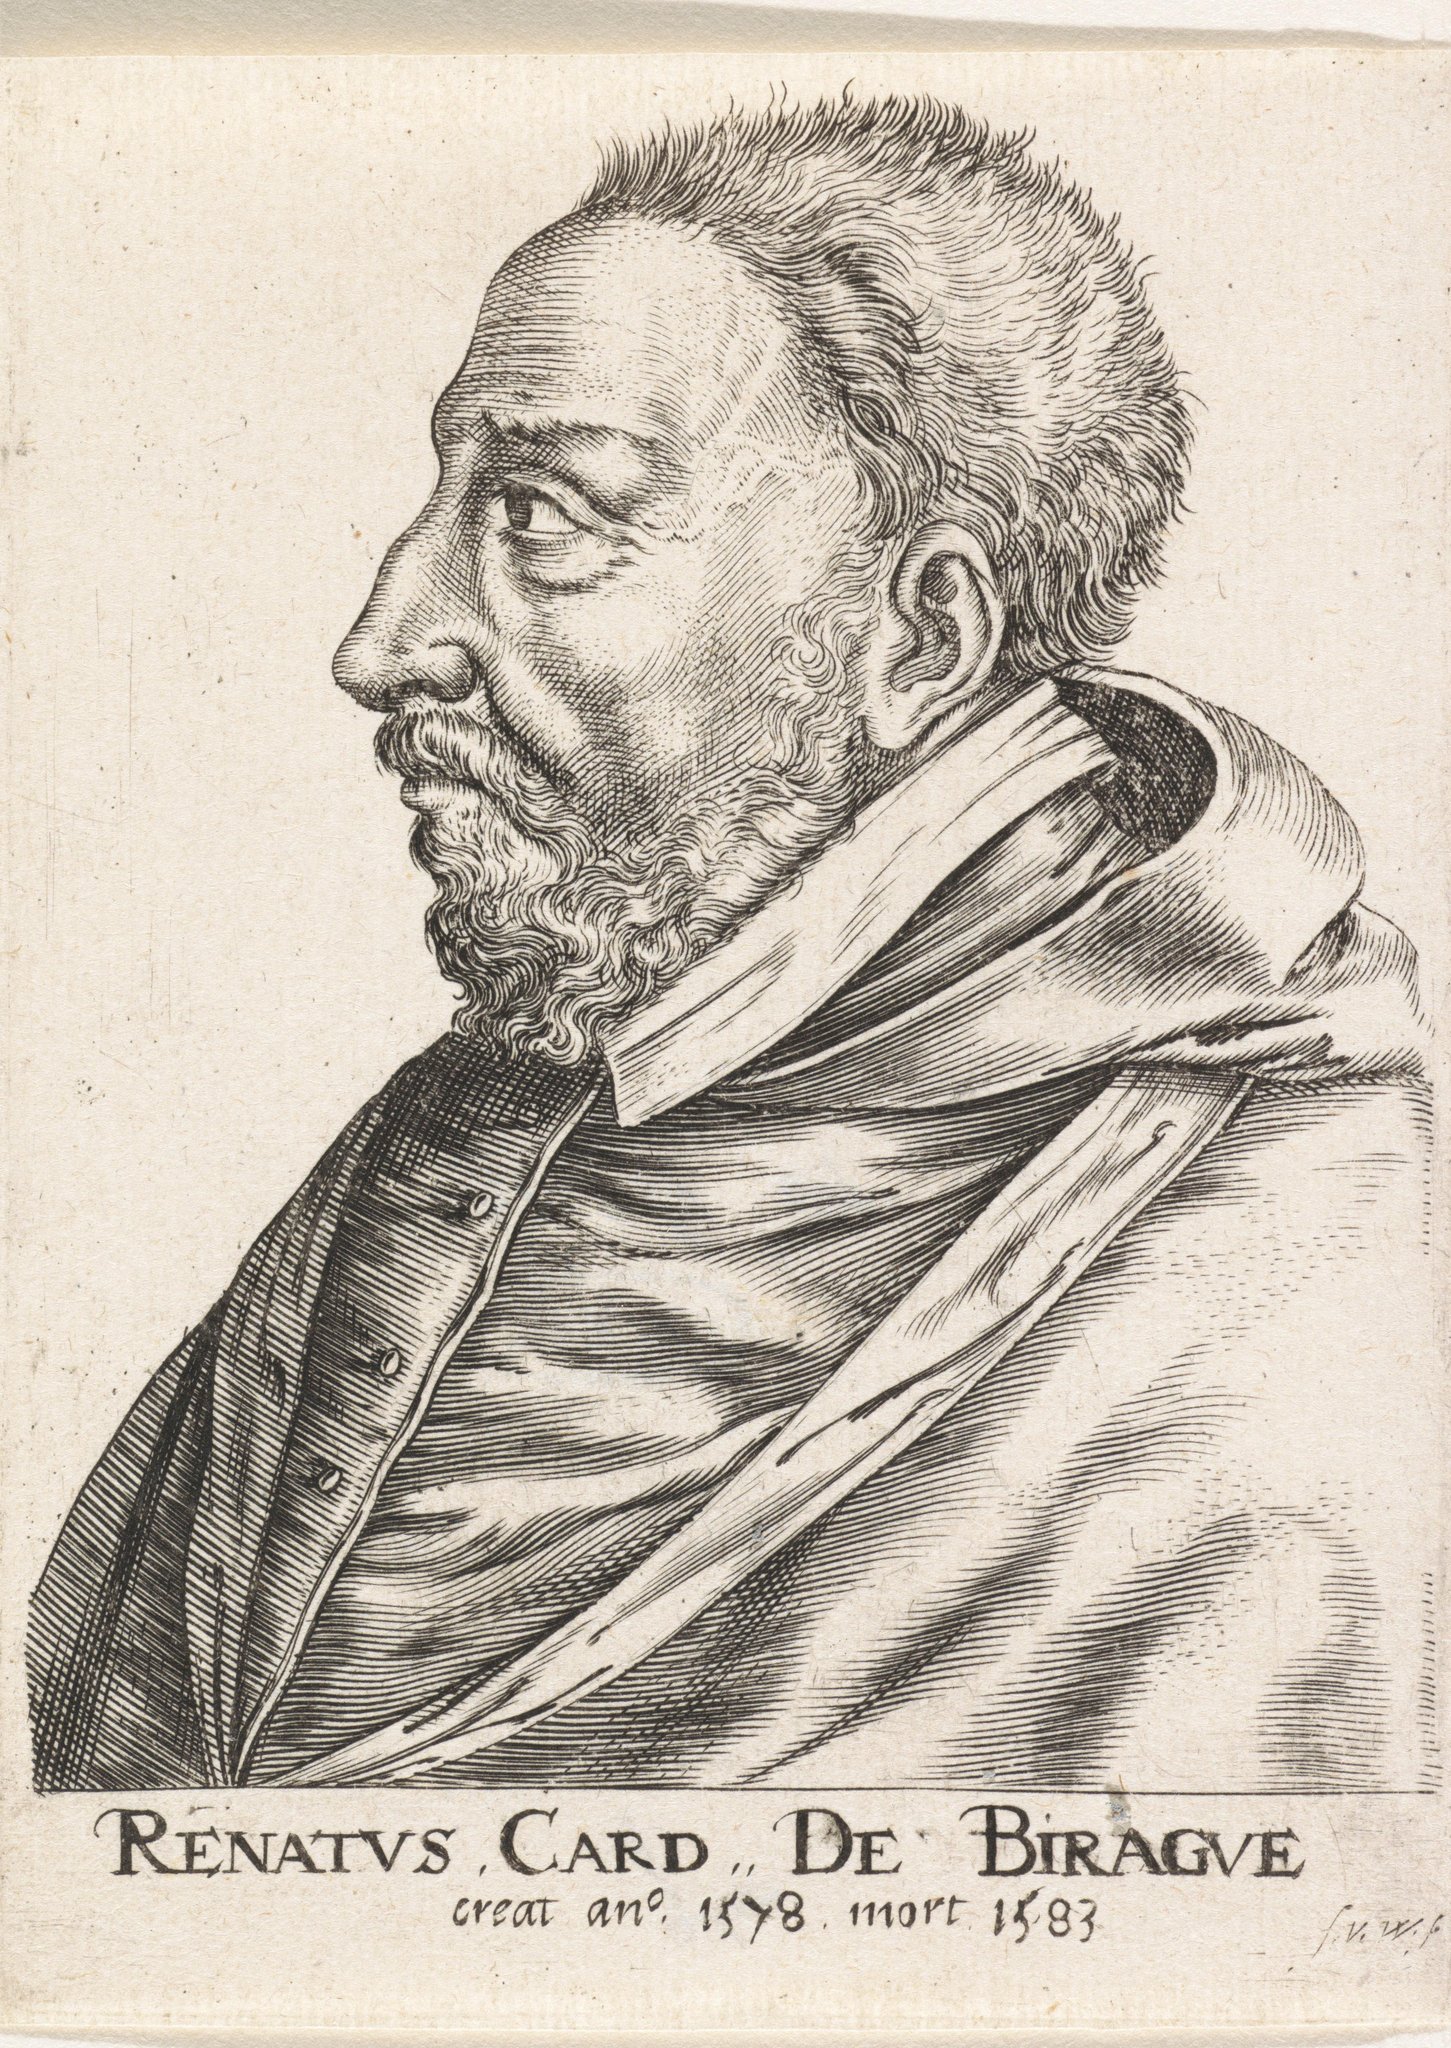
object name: print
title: Portret van de Franse kardinaal René de Birague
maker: frans van den wijngaerde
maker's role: print maker, publisher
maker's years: 1614-1679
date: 1644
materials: paper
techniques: engraving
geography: antwerp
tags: cardinal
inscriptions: collector's mark: Lugt 2228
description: Prent gebruikt in: Albi, Henri. Eloges historiques des Cardinaux illustres François et etrangers mis en parallele. Parijs: Anthoine de Cay, 1644.